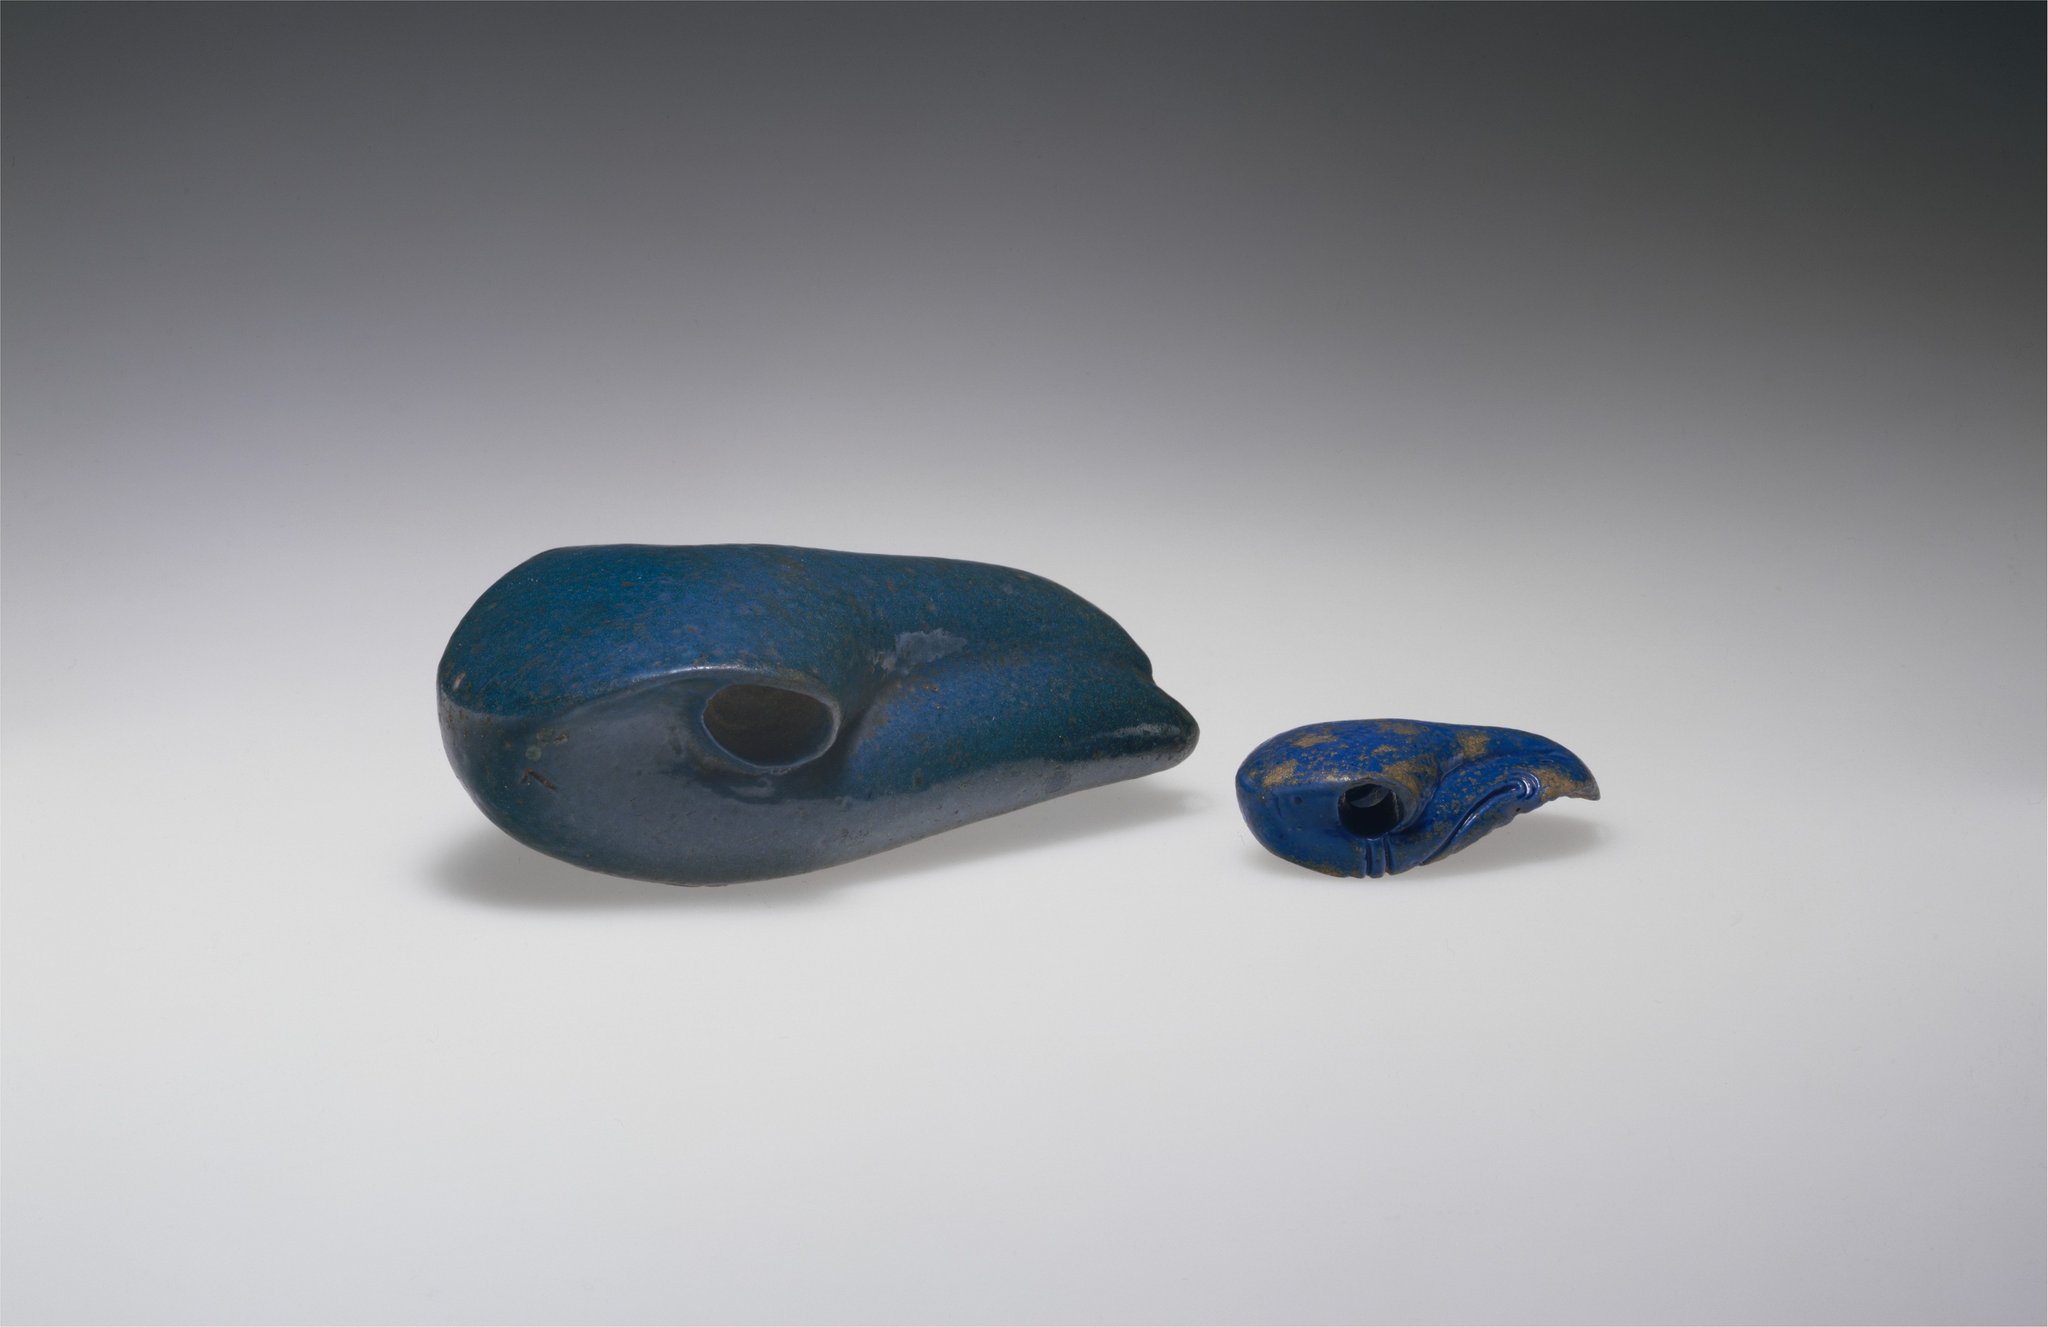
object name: furniture ornament, cobra head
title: Cobra head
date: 1390-1352 BCE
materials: faience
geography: egypt